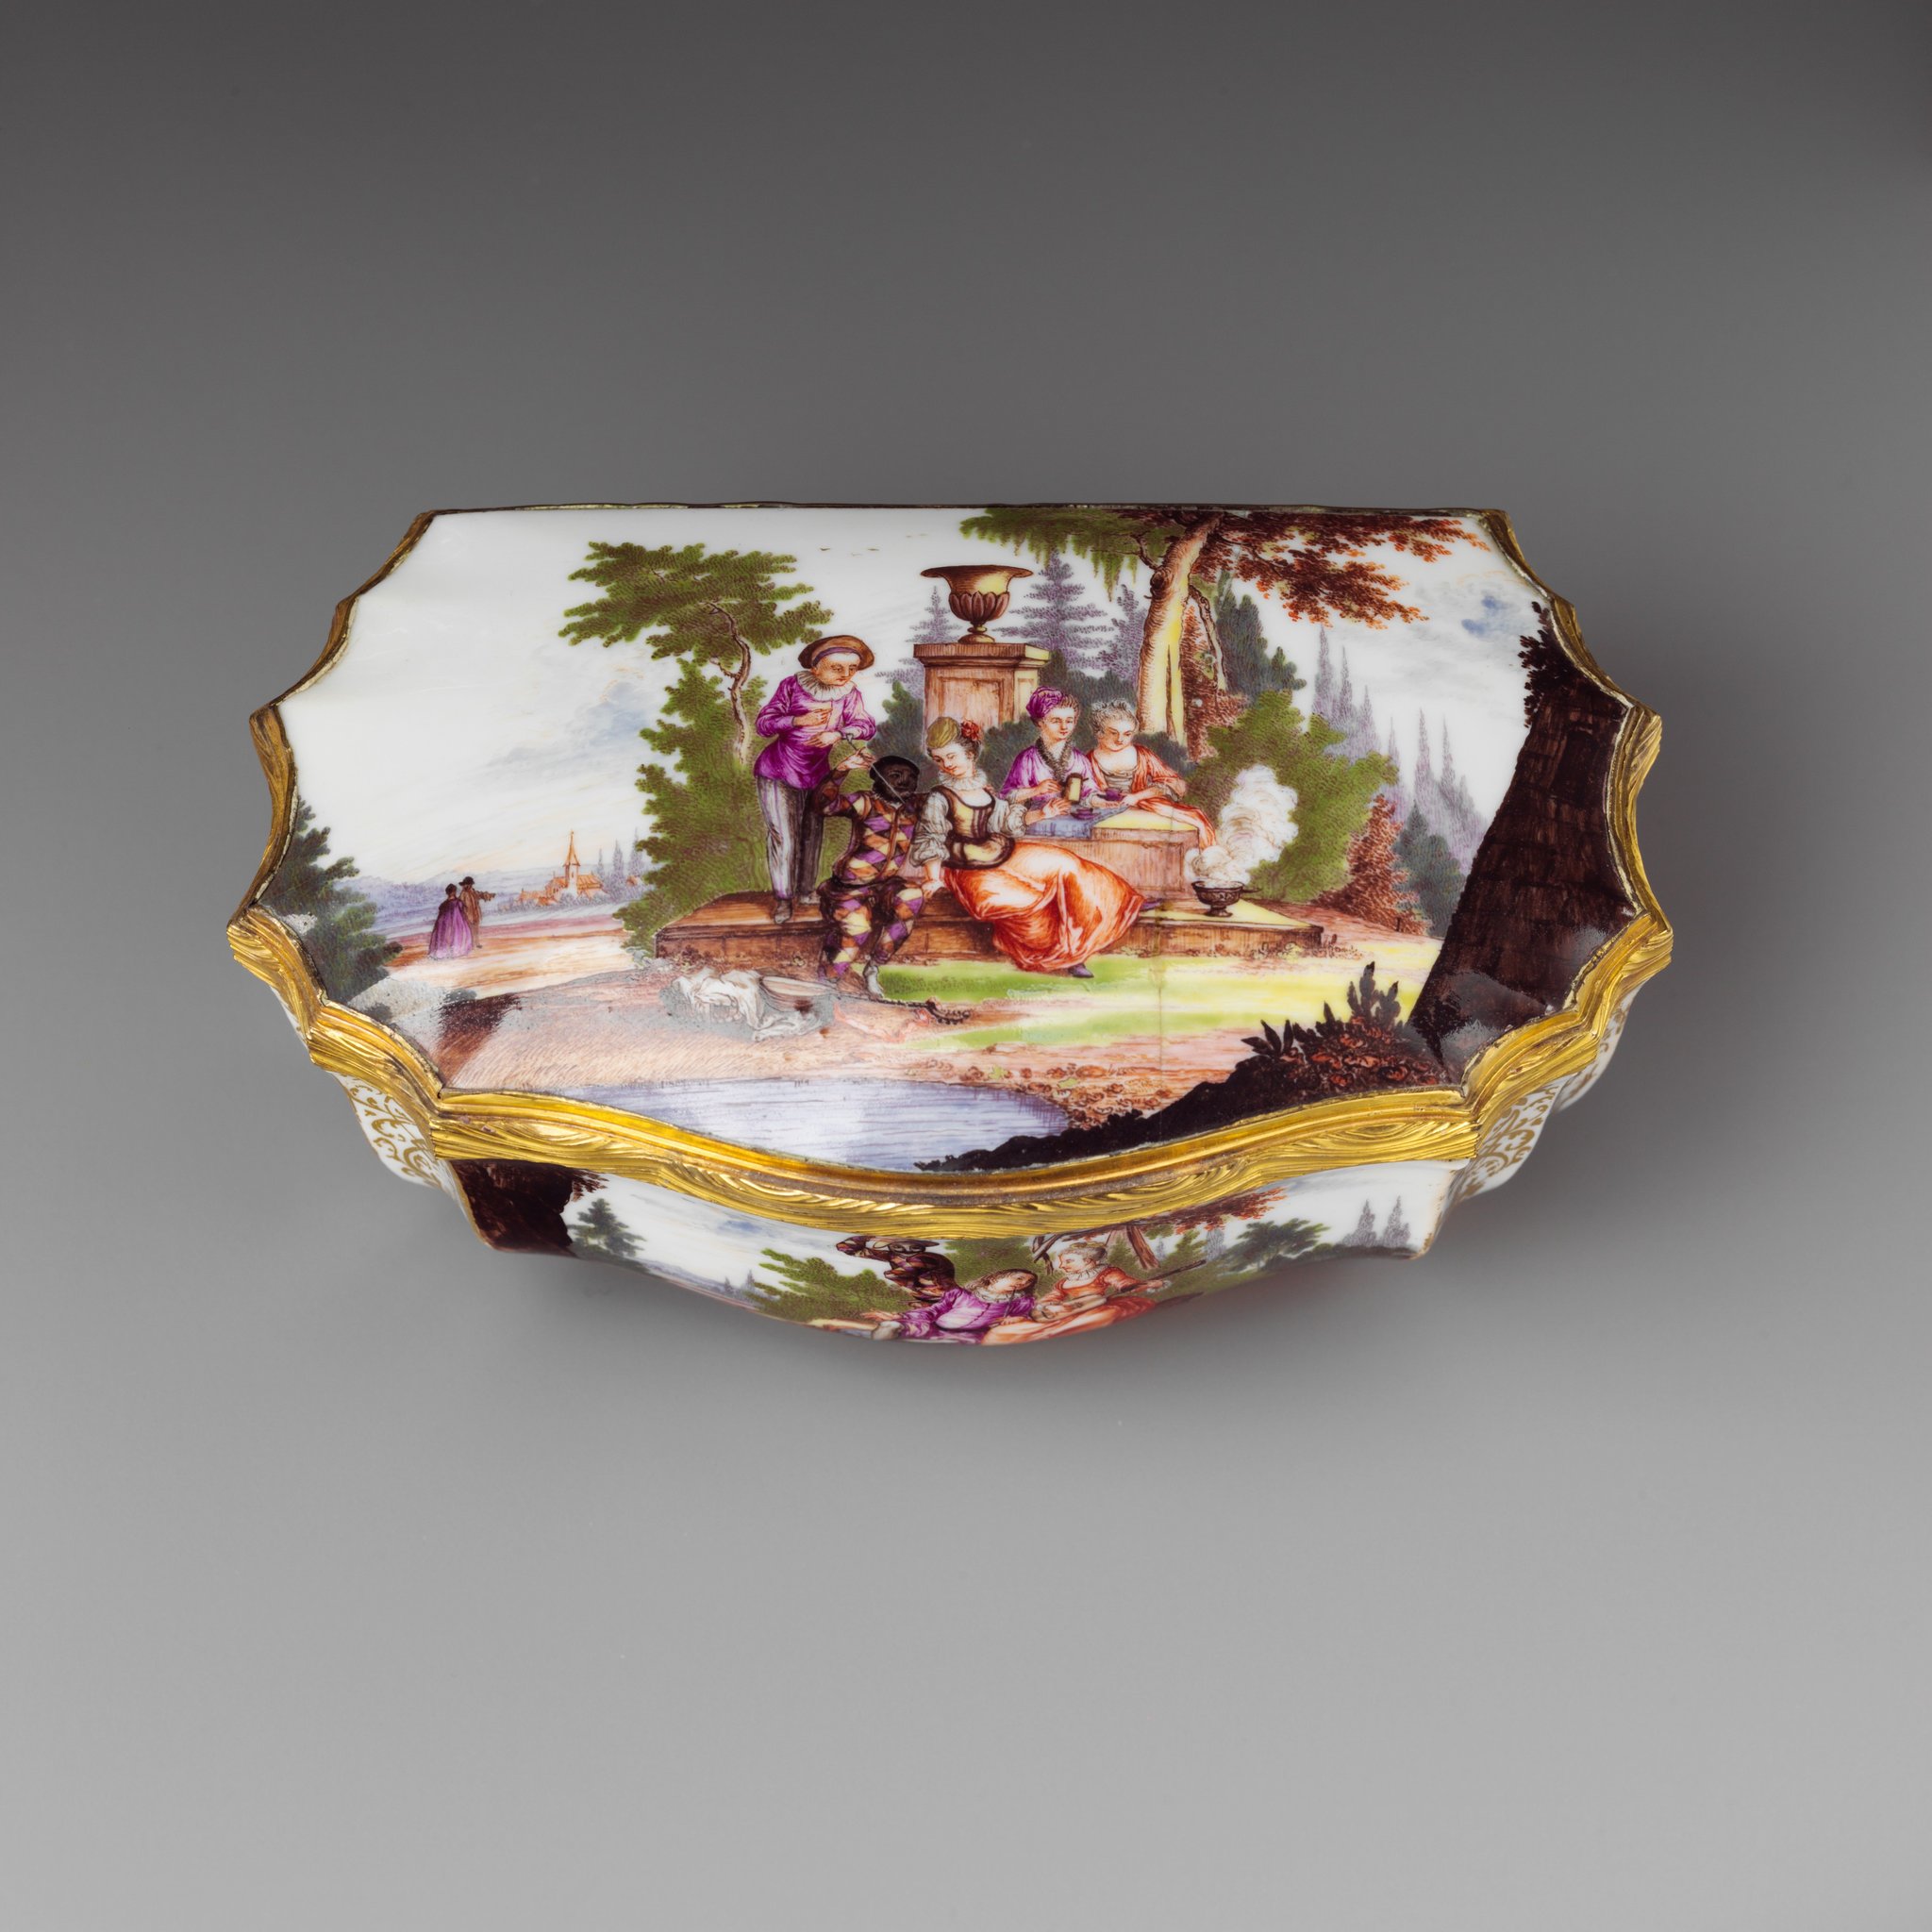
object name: snuffbox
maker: meissen manufactory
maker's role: manufactory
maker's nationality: german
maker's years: 1710-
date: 1750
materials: gold, hard paste porcelain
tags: women,landscapes,trees